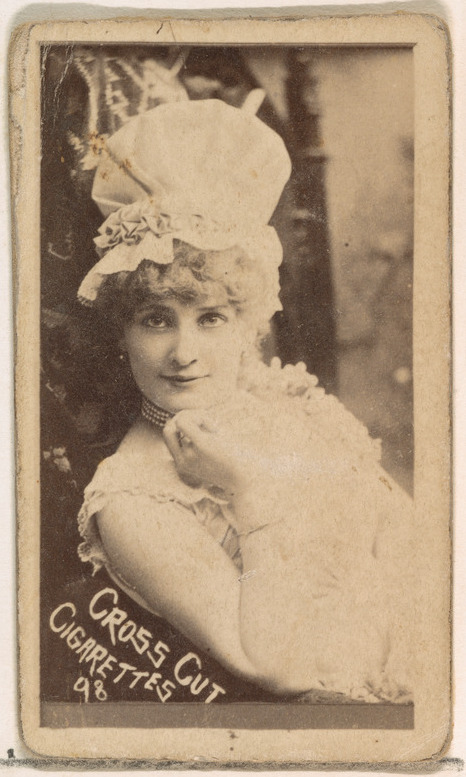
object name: print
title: Card Number 98, from the Actors and Actresses series (N145-1) issued by Duke Sons & Co. to promote Cross Cut Cigarettes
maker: w. duke, sons & co.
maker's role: publisher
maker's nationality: american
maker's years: 1870-1920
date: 1880-1889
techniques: albumen silver print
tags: portraits,women,actresses